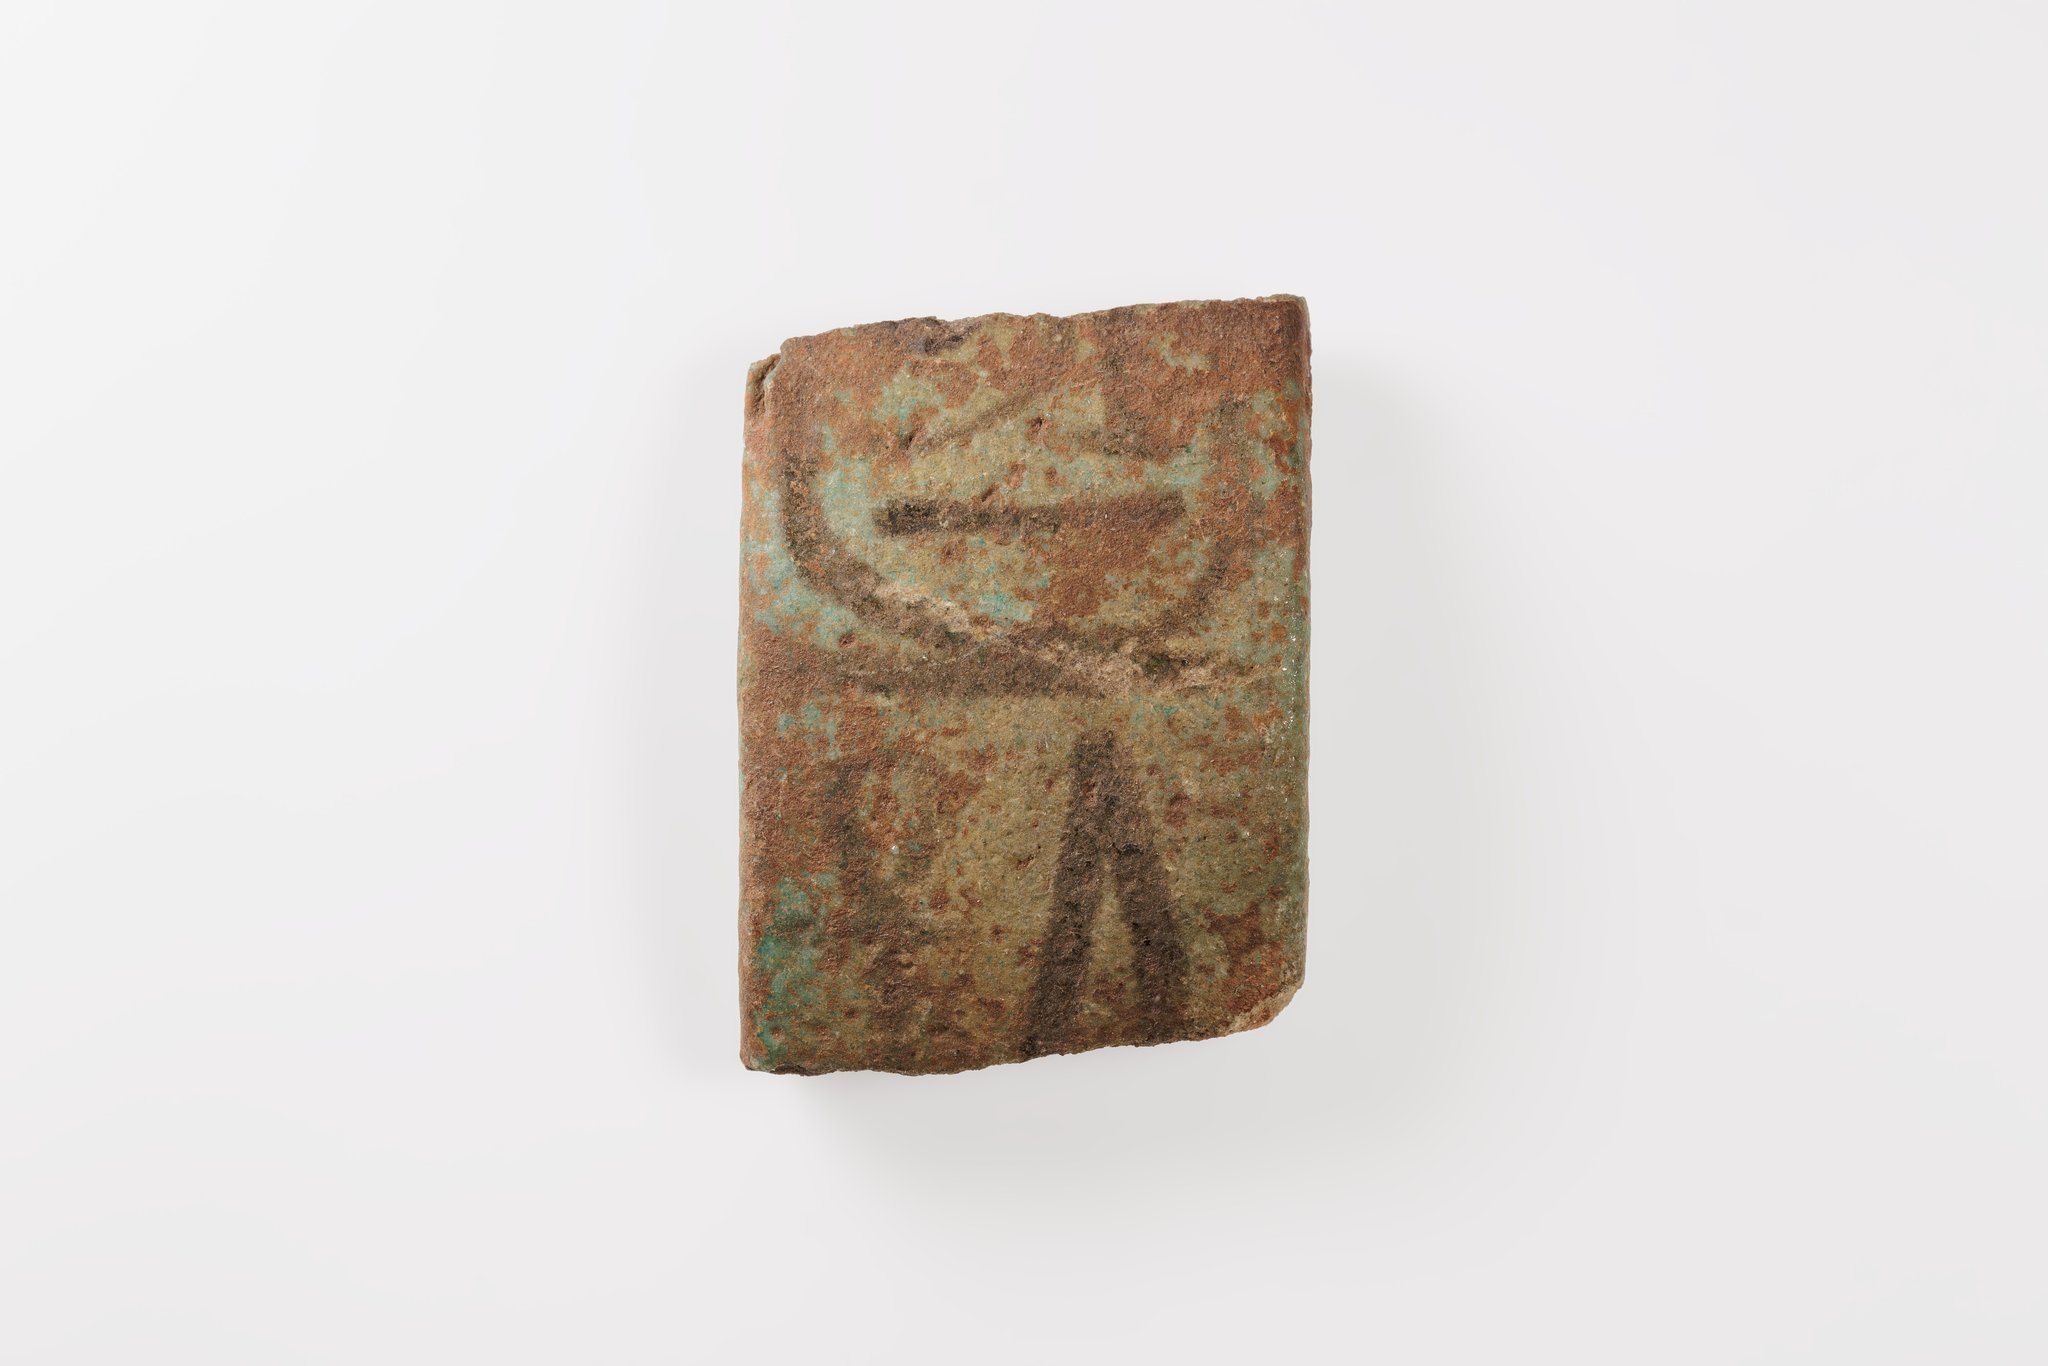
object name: votive bracelet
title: Fragment of a votive bracelet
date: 1295-1070 BCE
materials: faience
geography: egypt